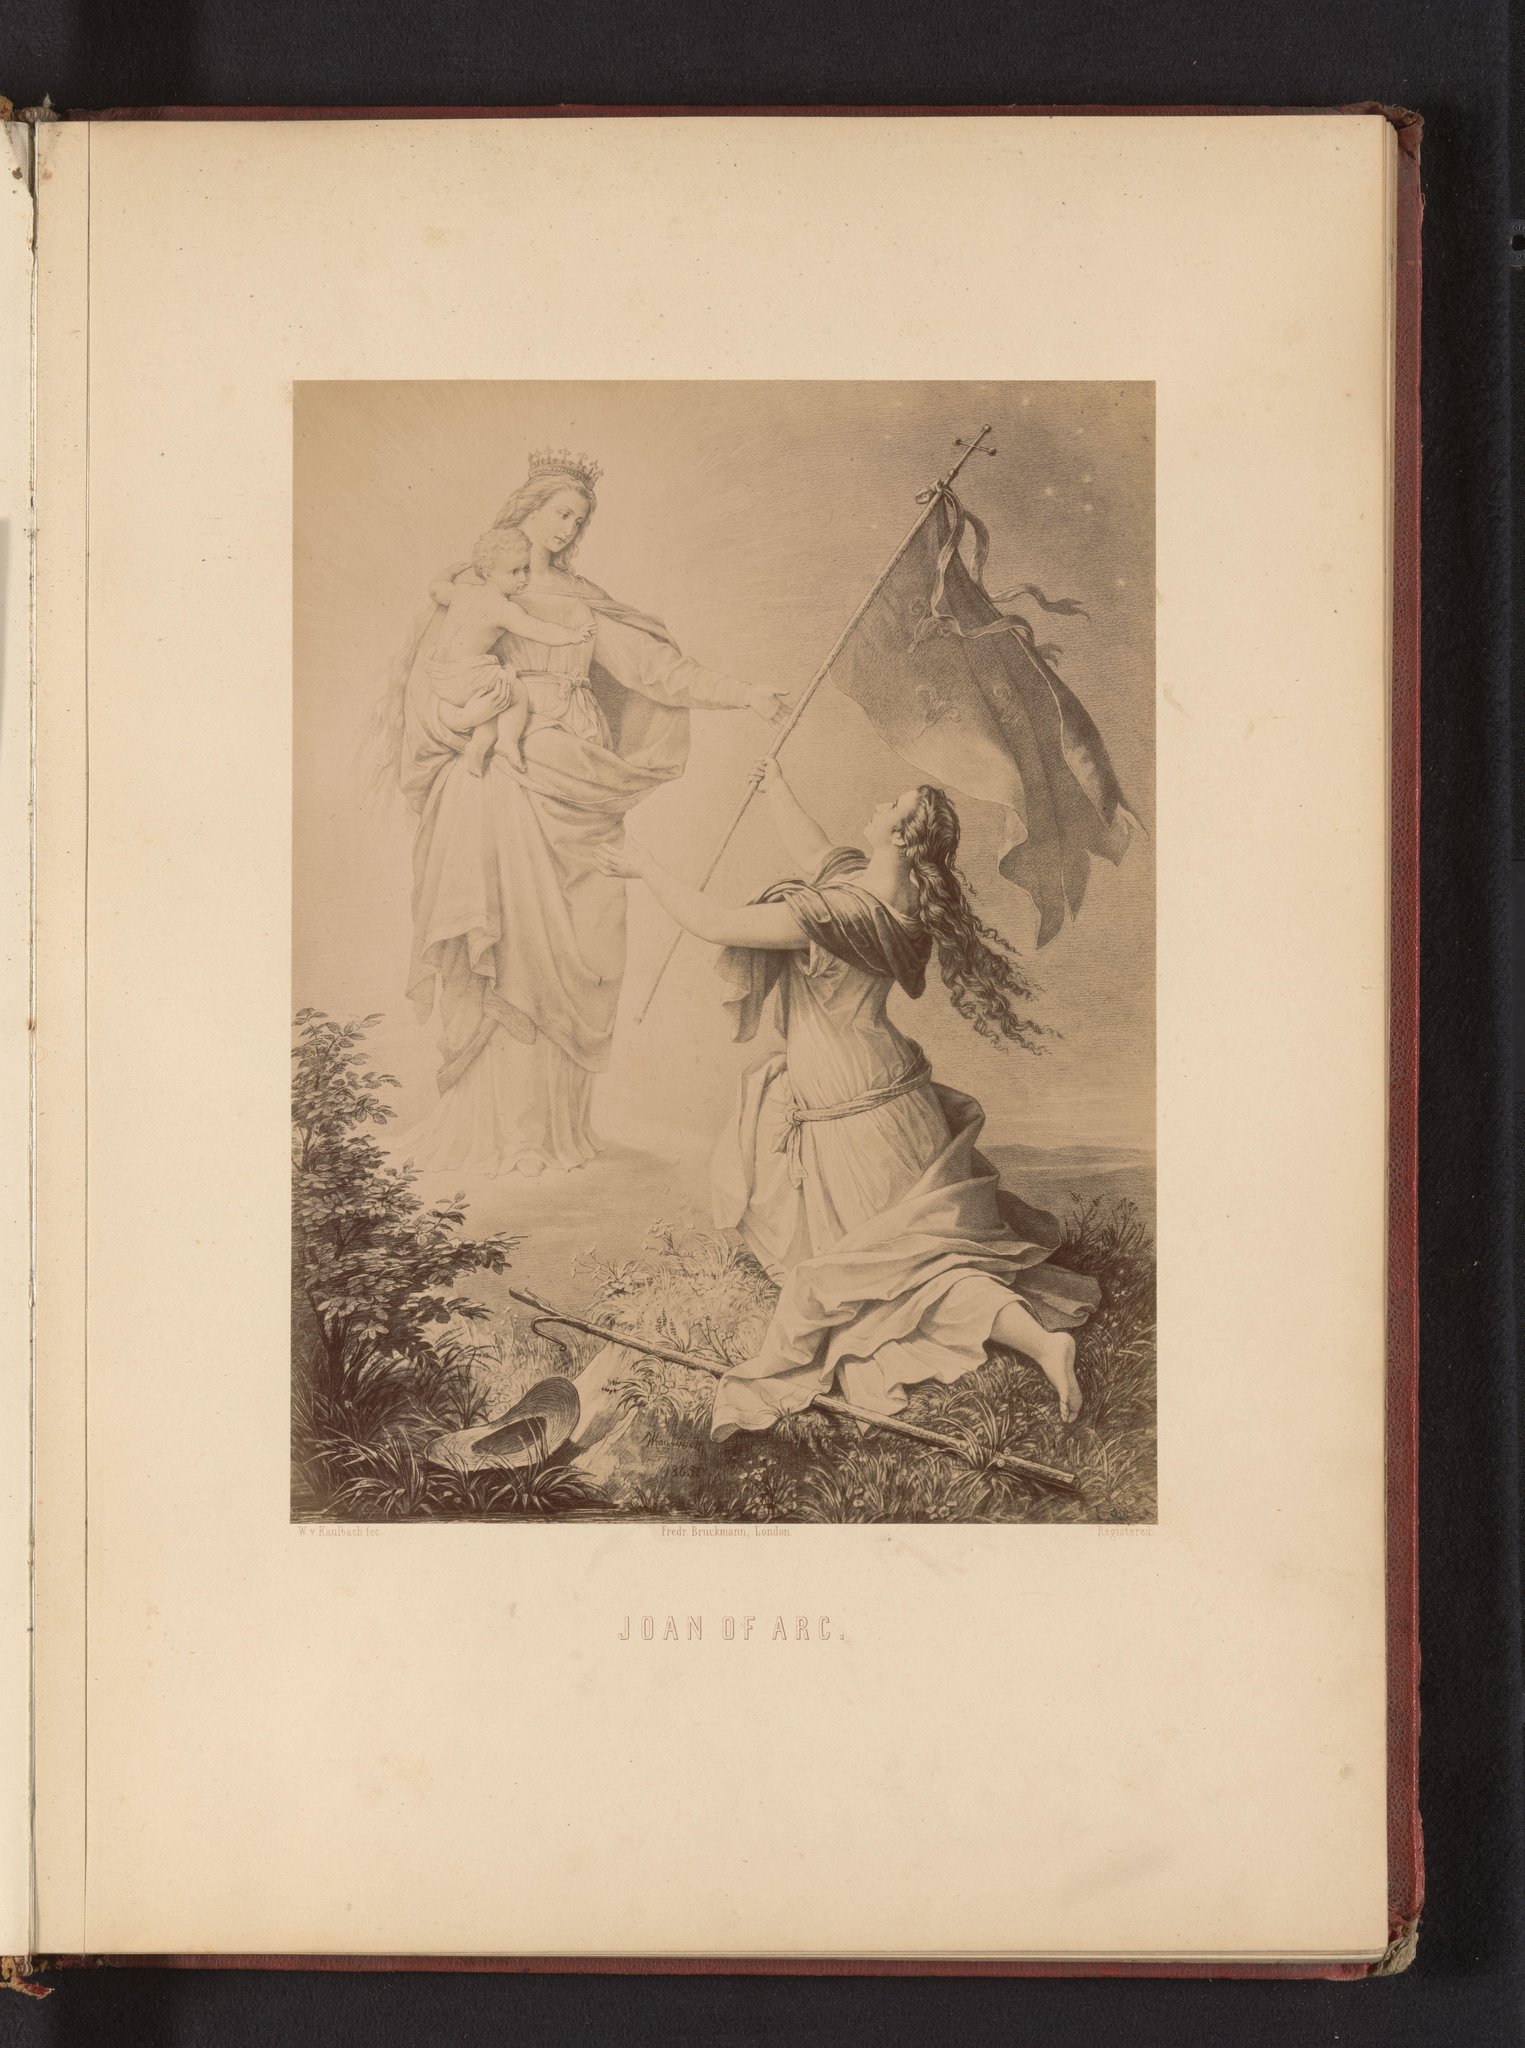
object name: reproduction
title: Joan of Arc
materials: photographic support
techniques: albumen print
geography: london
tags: joan of arc (jeanne d'arc); possible attributes: armour, banner, lance, sword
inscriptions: inscription: ‘Registered.’